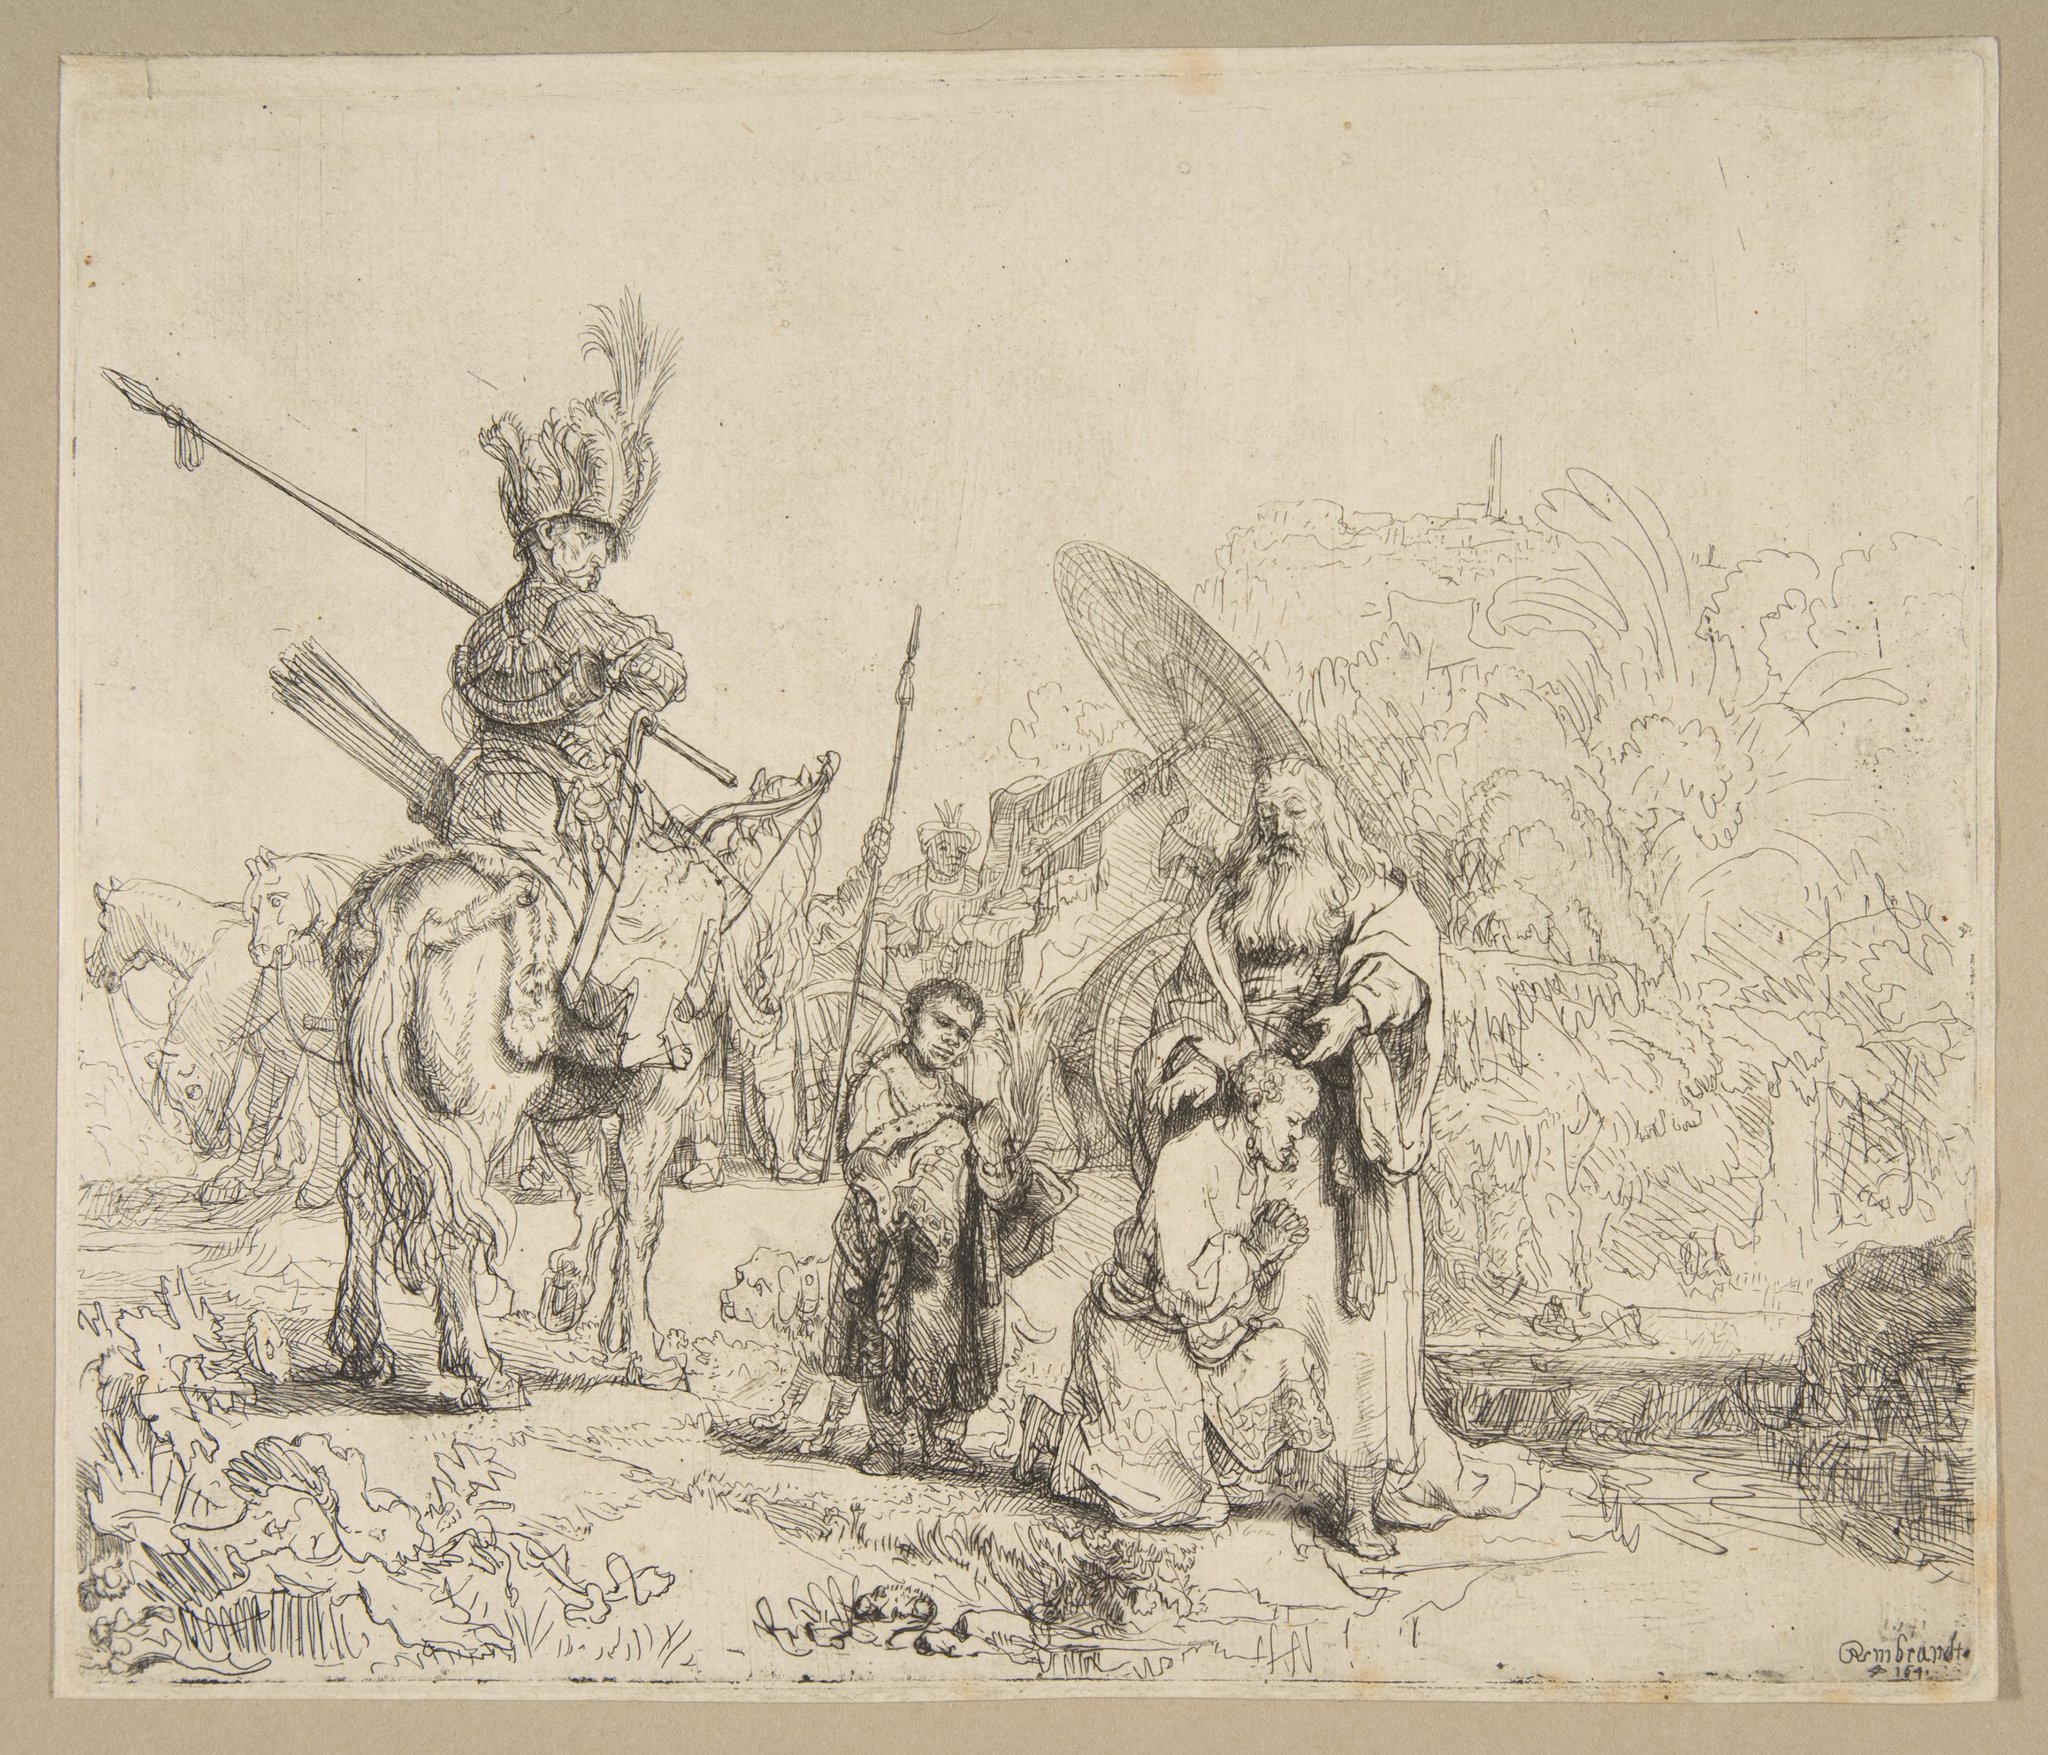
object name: print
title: The Baptism of The Eunuch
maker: rembrandt van rijn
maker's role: artist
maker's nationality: dutch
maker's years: 1606-1669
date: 1641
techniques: etching, wash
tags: soldiers,boys,men,horses